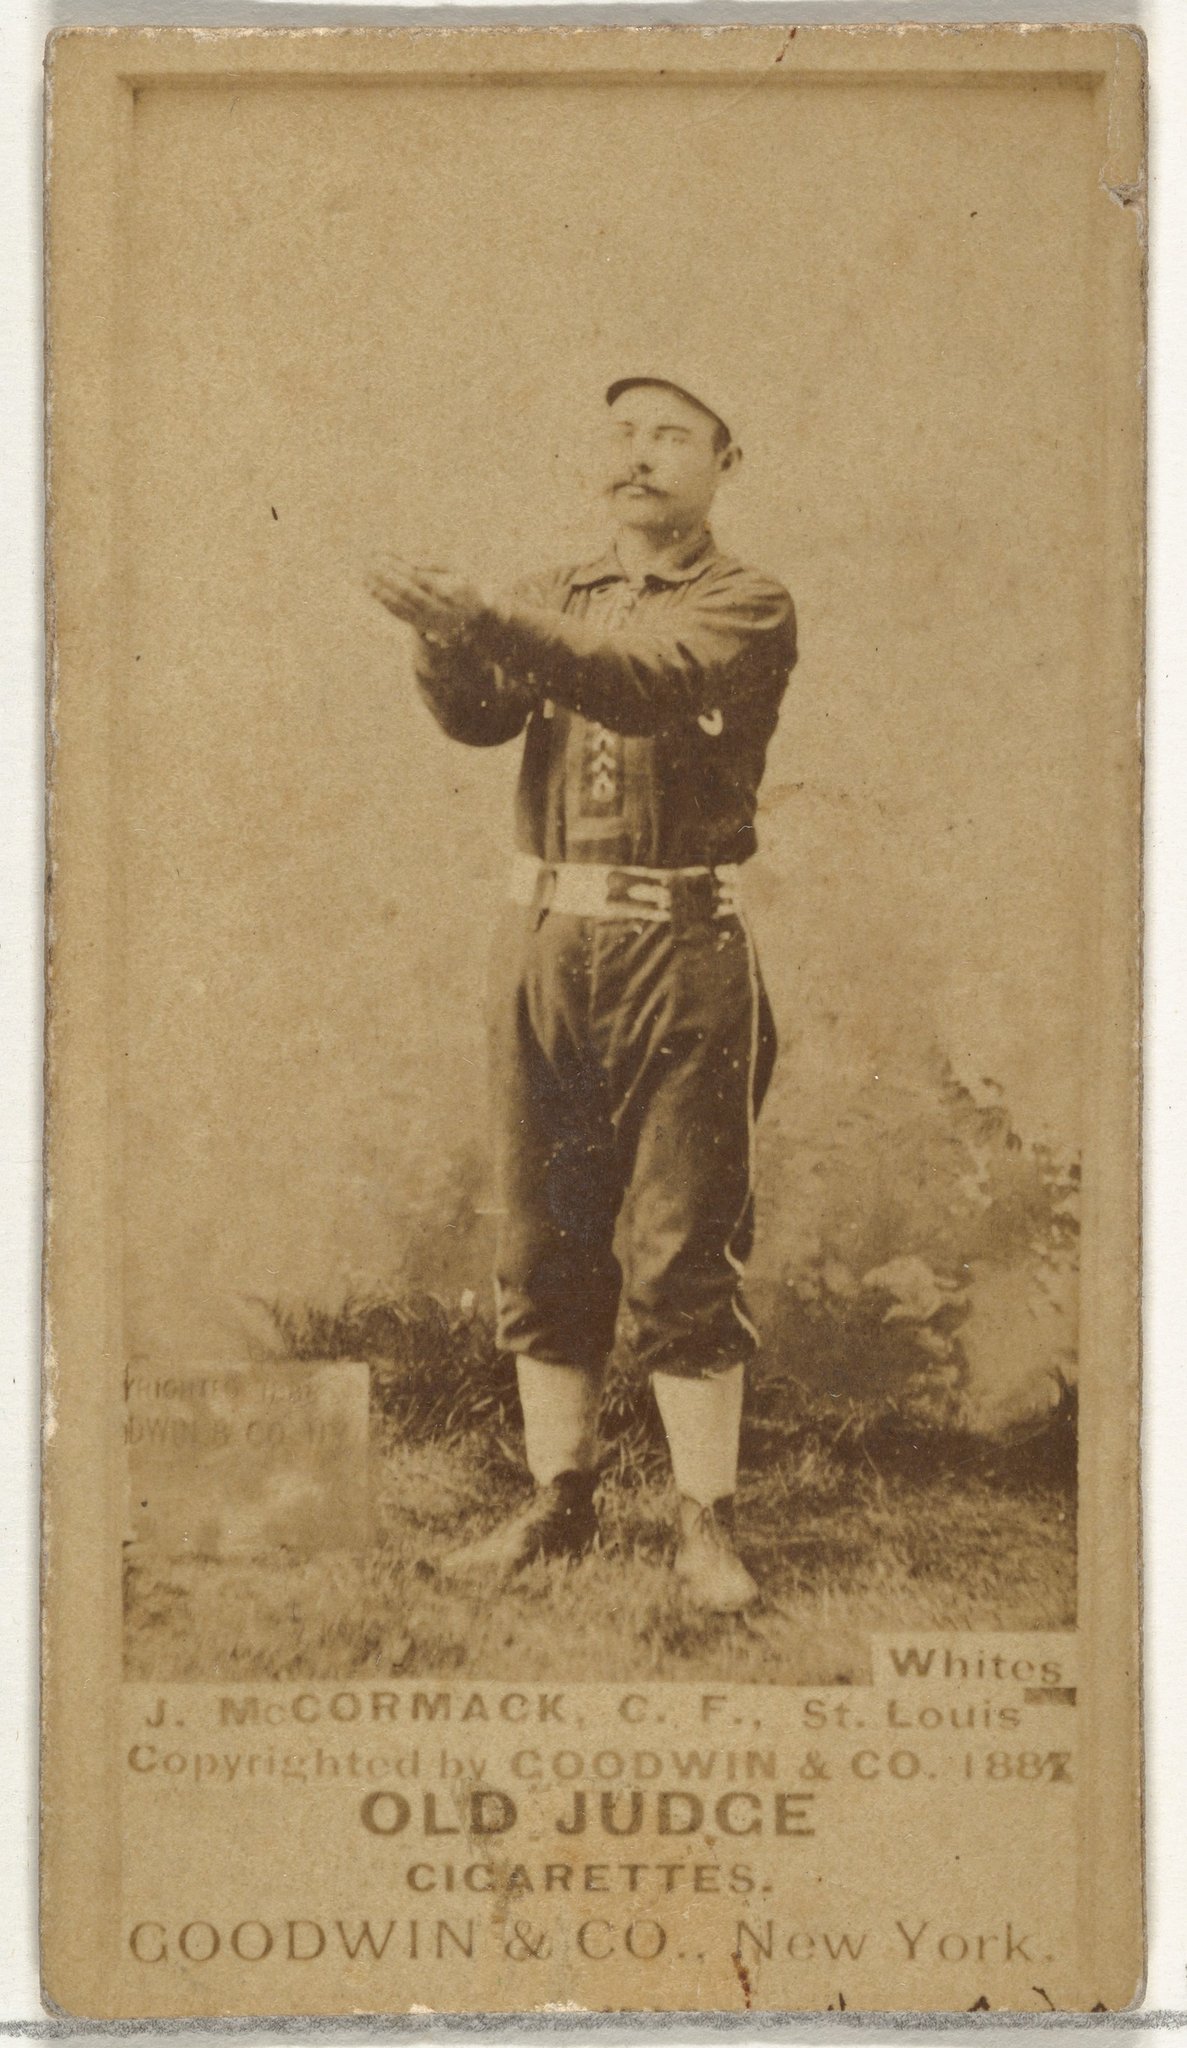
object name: baseball card, photograph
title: McCormack, Center Field, St. Louis Whites, from the Old Judge series (N172) for Old Judge Cigarettes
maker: goodwin & company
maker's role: publisher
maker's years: 1850-1950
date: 1888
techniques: albumen silver print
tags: men,portraits,baseball,athletes